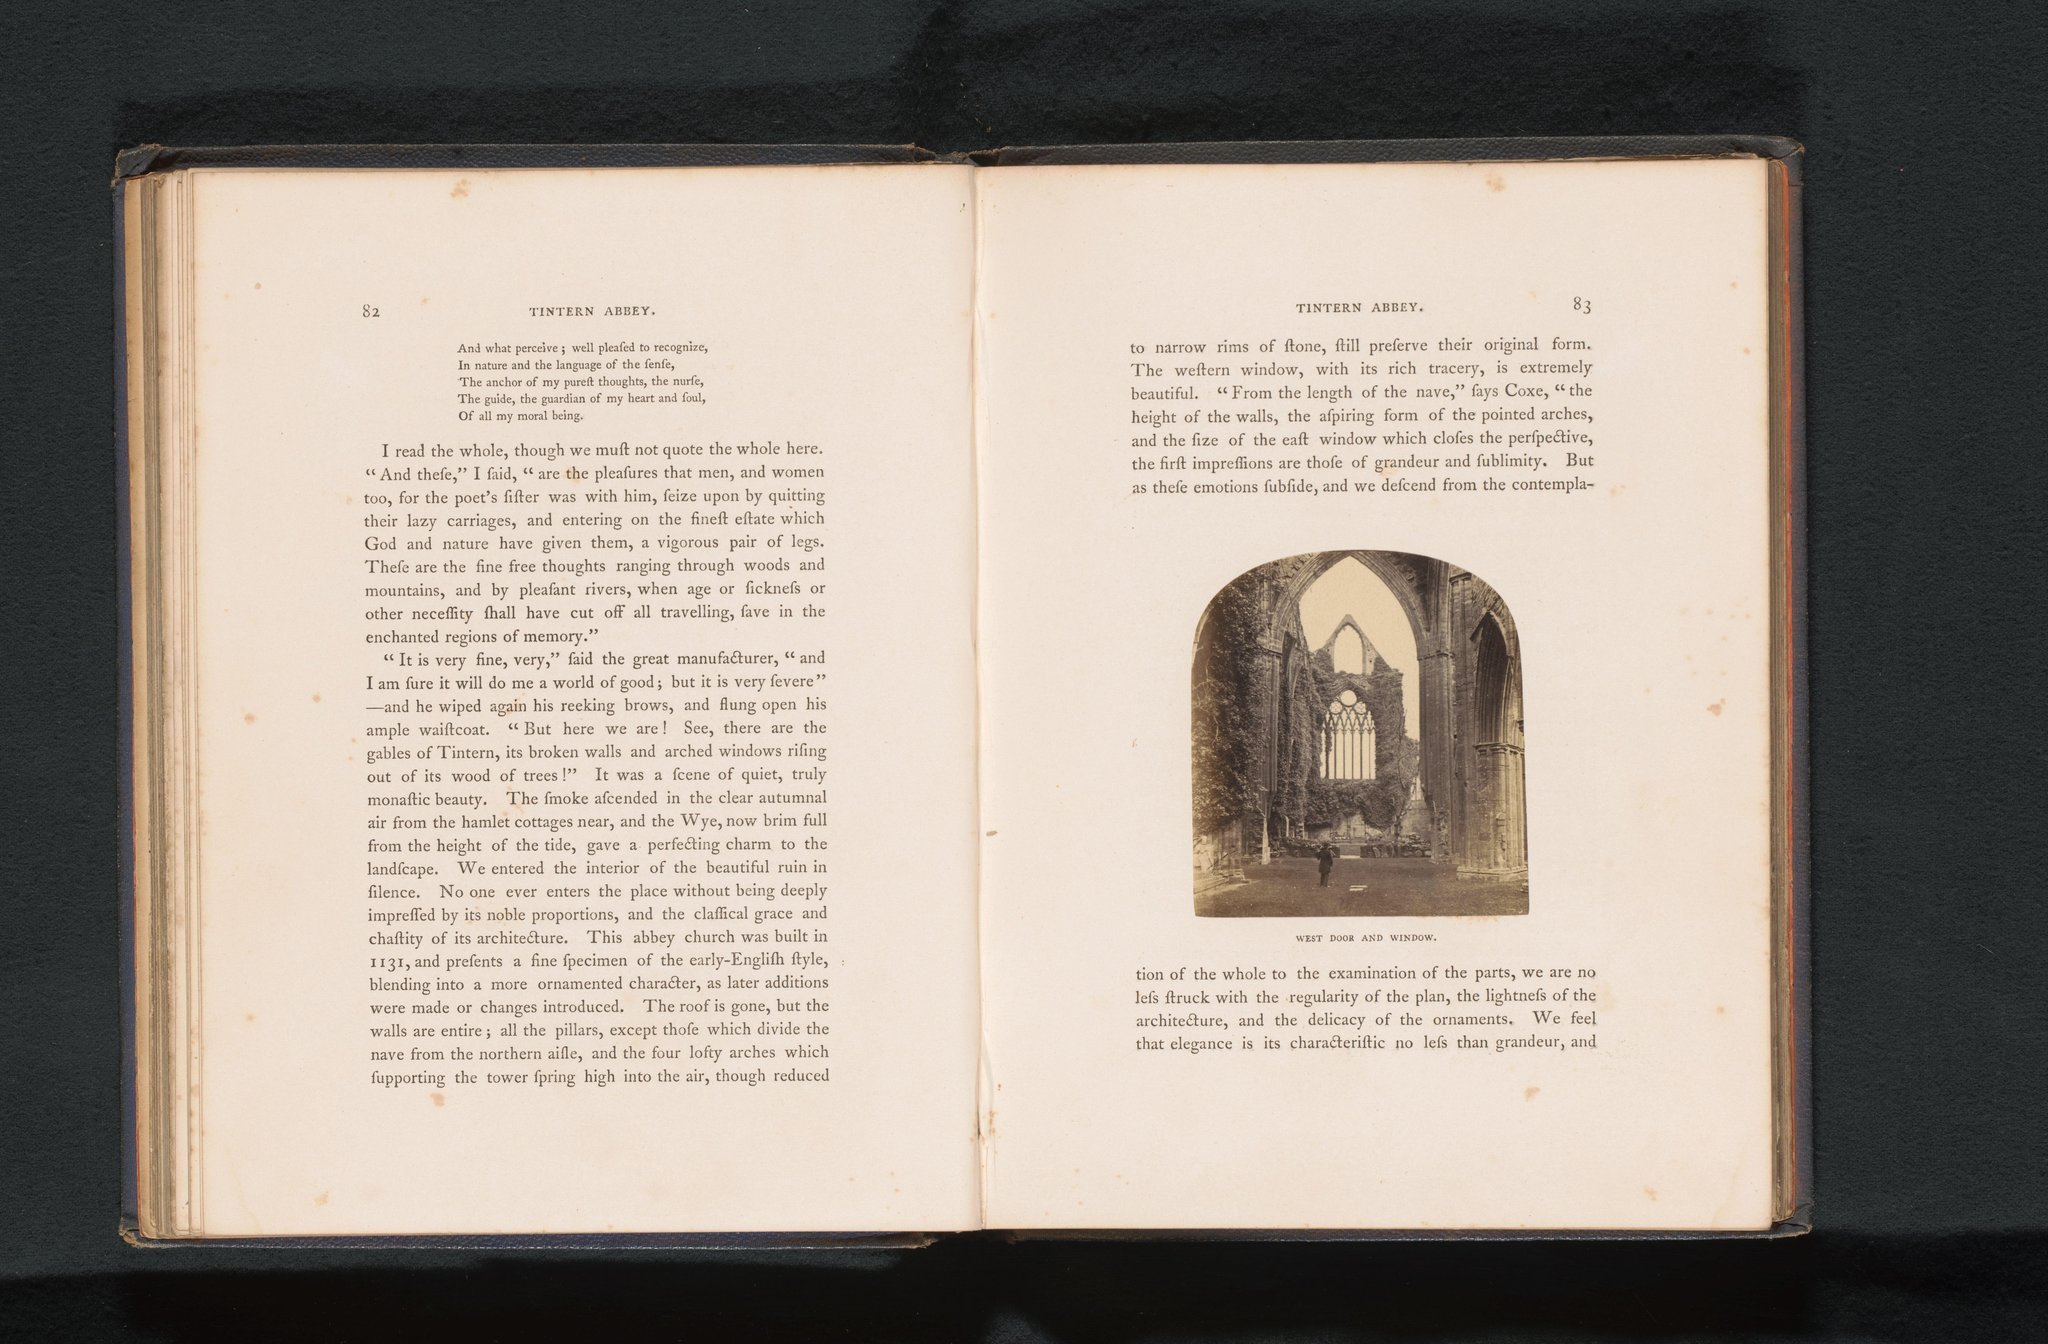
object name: photograph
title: West door and window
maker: william russell sedgfield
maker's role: fotograaf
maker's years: 1826-1902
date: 1857-1862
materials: photographic support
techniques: albumen print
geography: tintern abbey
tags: ruin of church, monastery, etc.